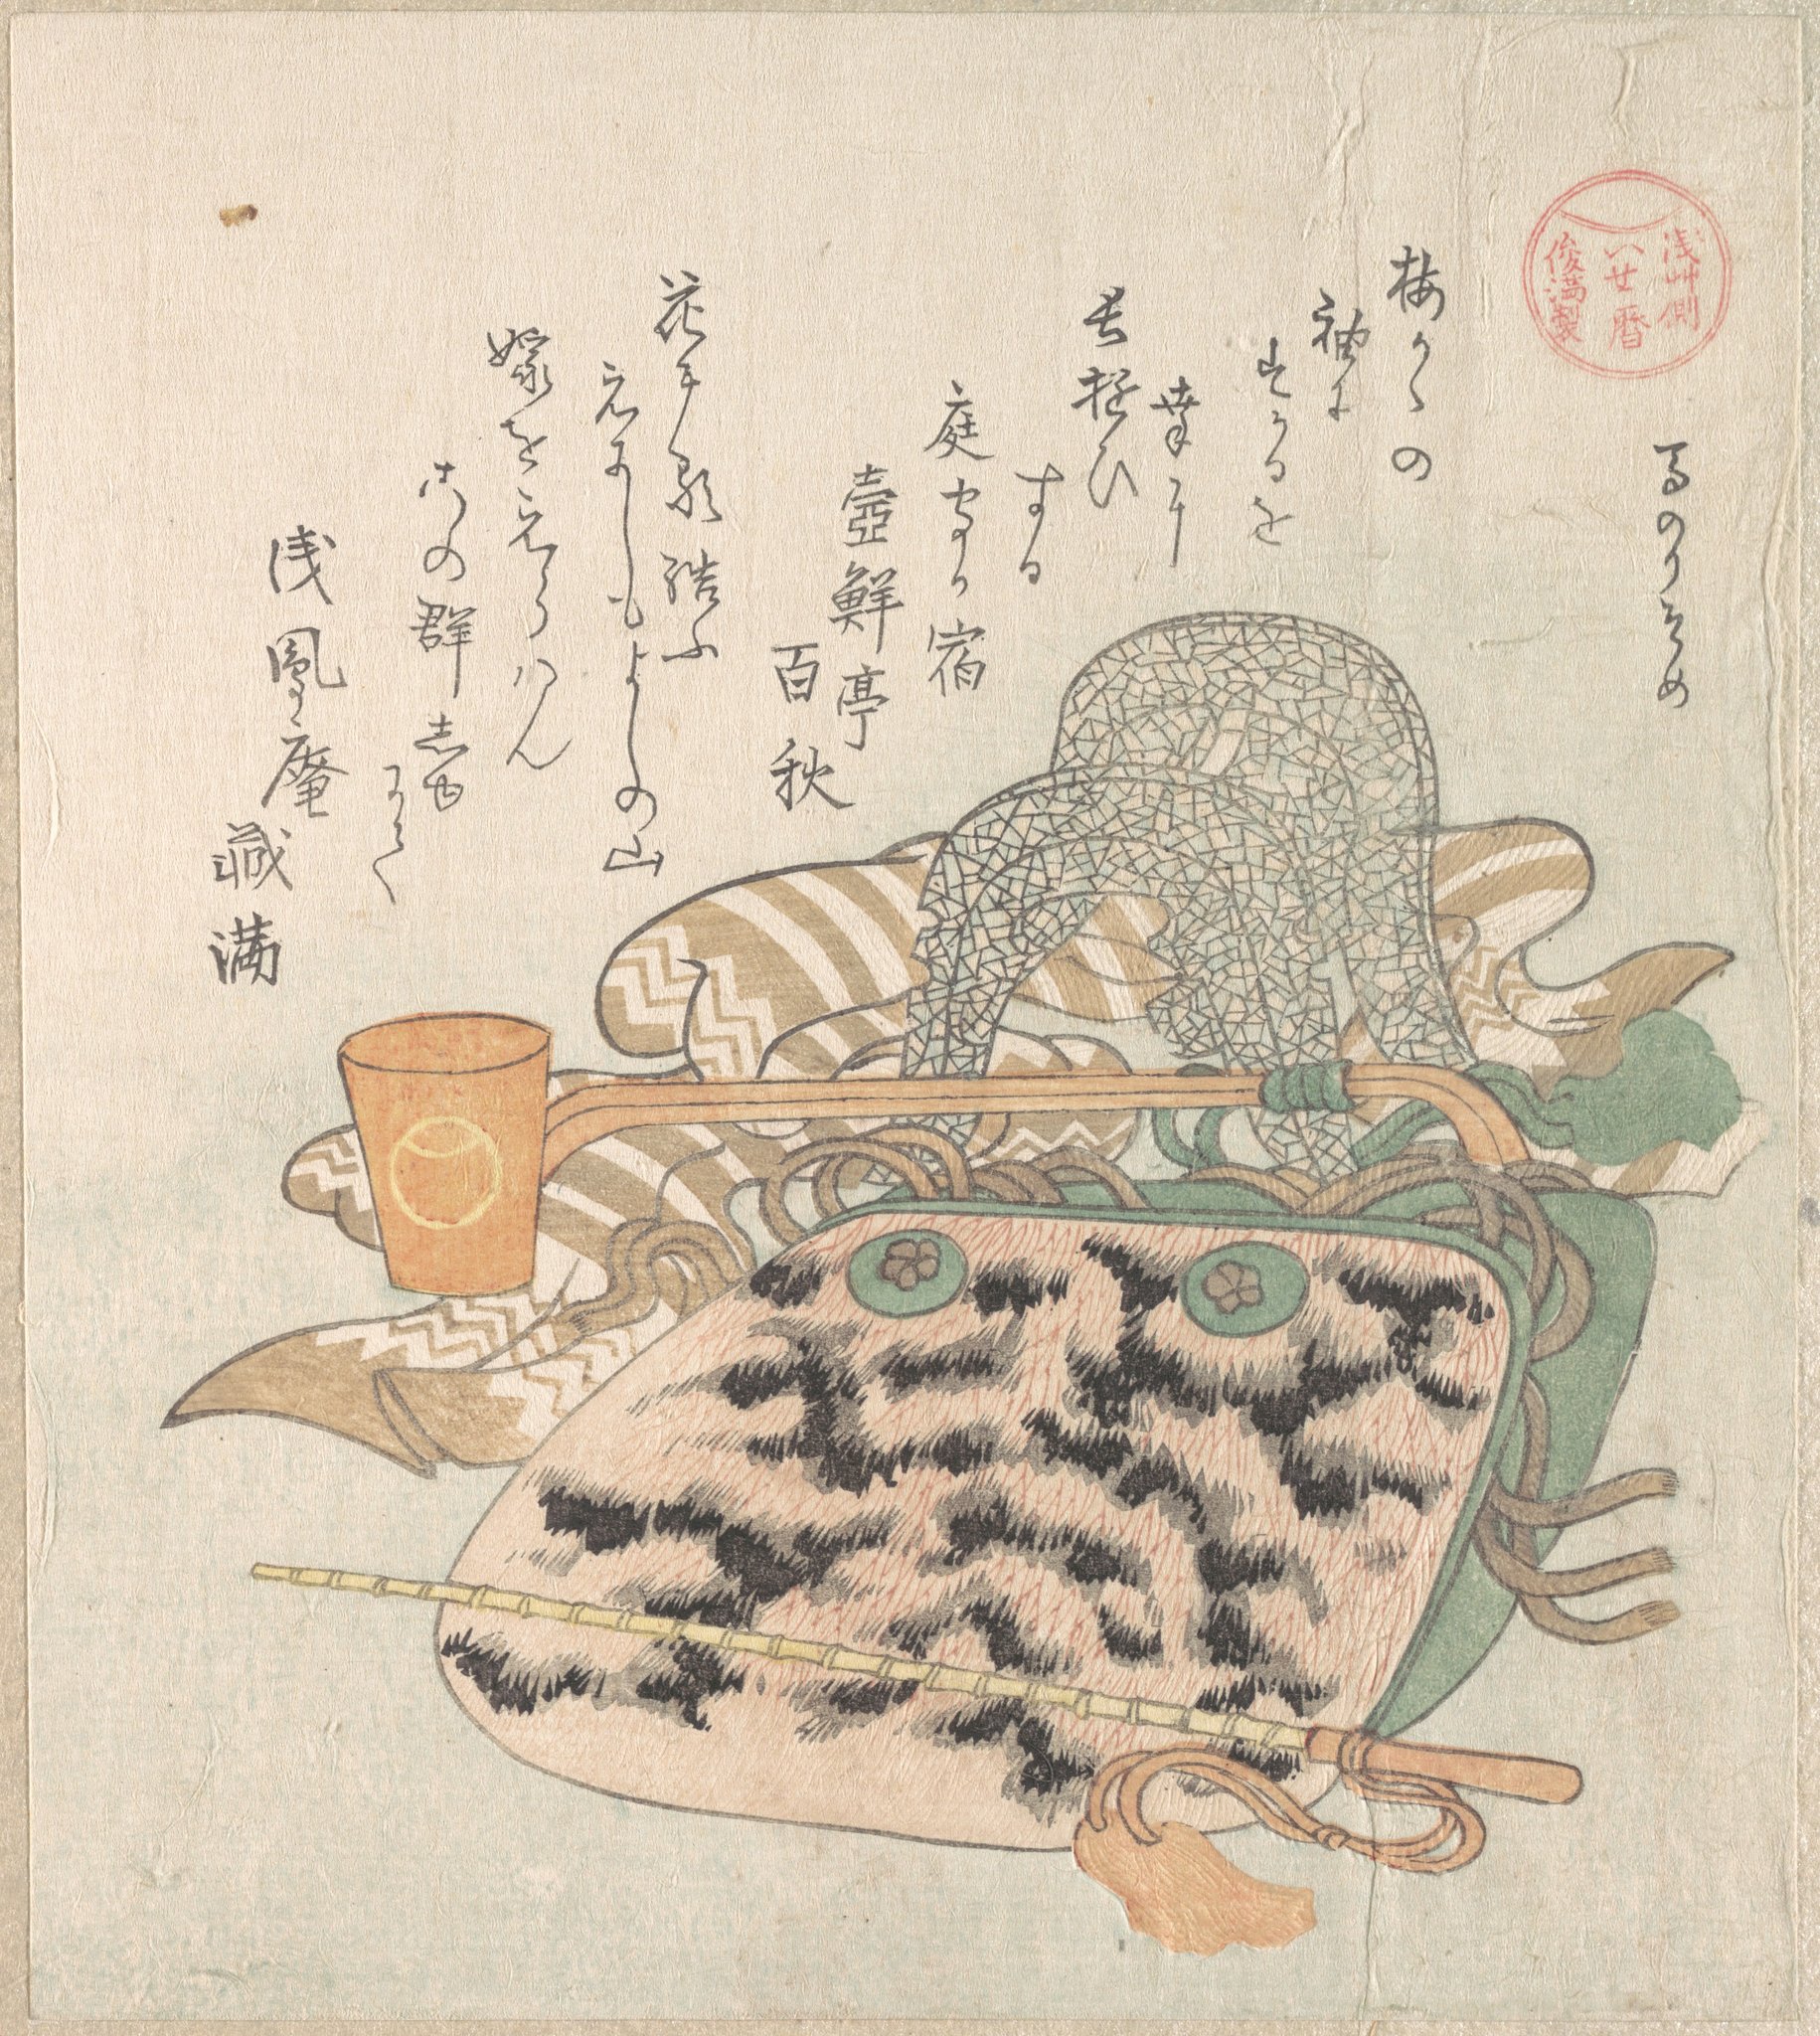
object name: woodblock print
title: Saddle, Horse-Dipper and Other Harness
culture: japanese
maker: kubo shunman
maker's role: artist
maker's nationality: japanese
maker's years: 1757-1820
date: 1801-1900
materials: ink, paper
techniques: surimono, woodblock print